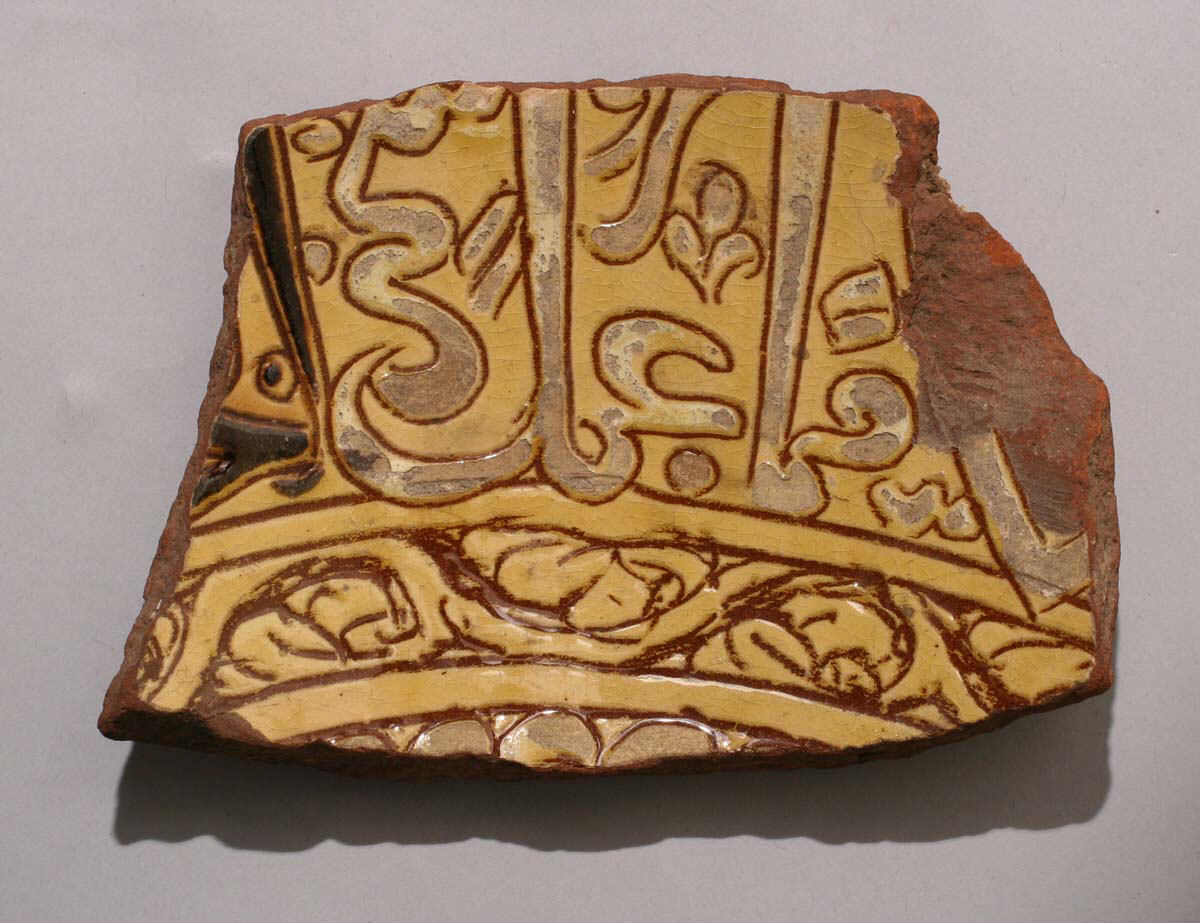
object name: fragment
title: Ceramic Fragment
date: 1301-1500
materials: earthenware, glaze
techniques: coloring, incising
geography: egypt